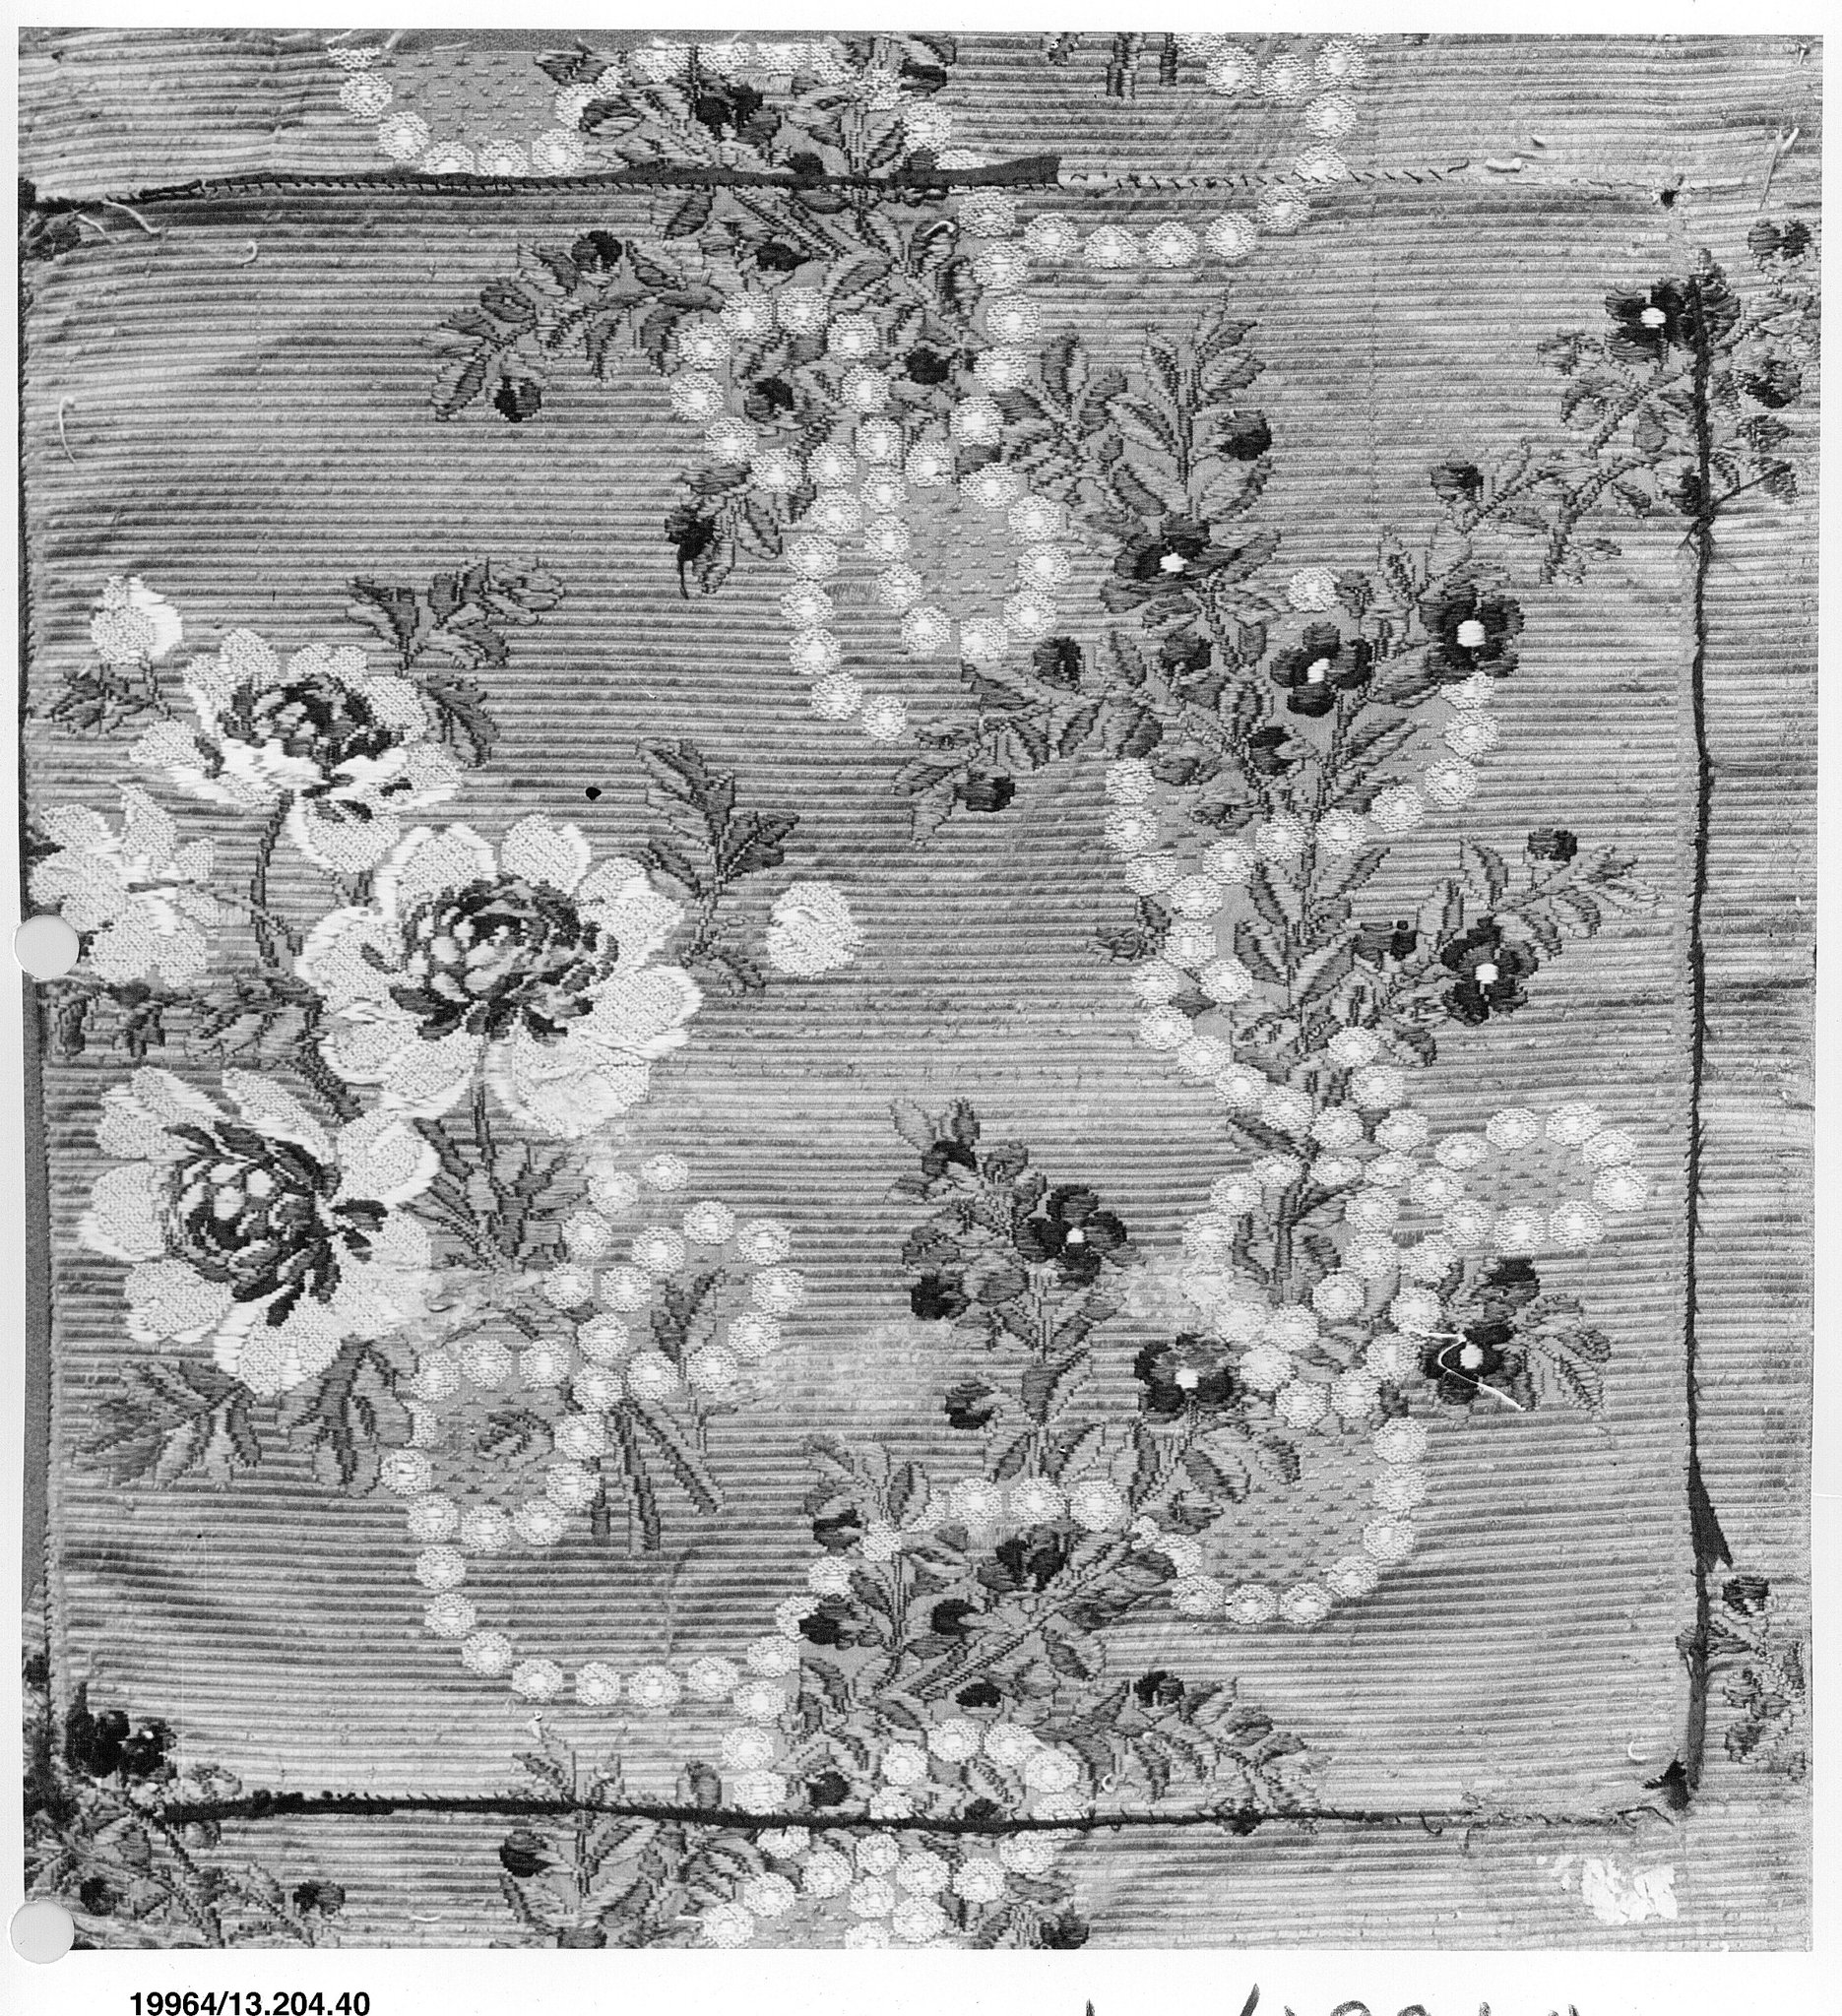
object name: piece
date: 1774-1793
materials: silk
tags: flowers,leaves